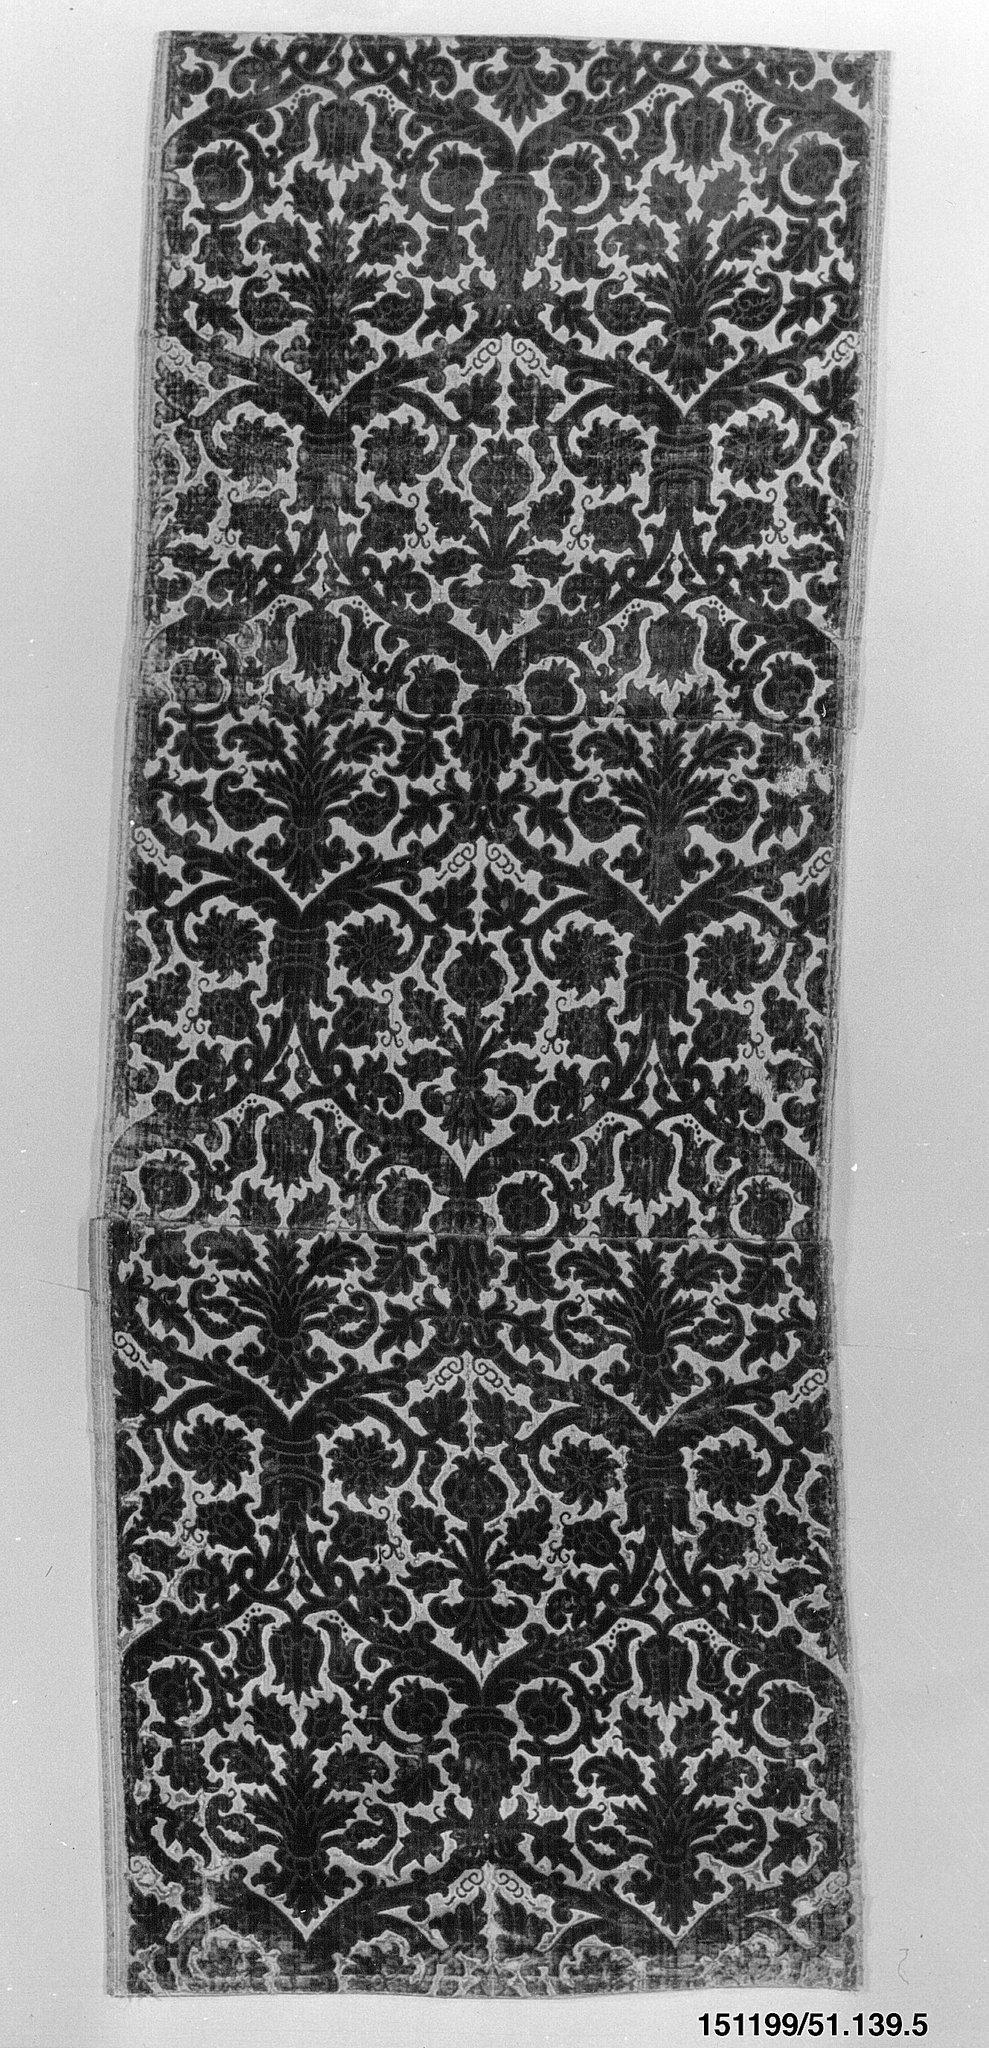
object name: panel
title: Length of velvet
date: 1501-1533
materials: silk, velvet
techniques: cutting, voiding